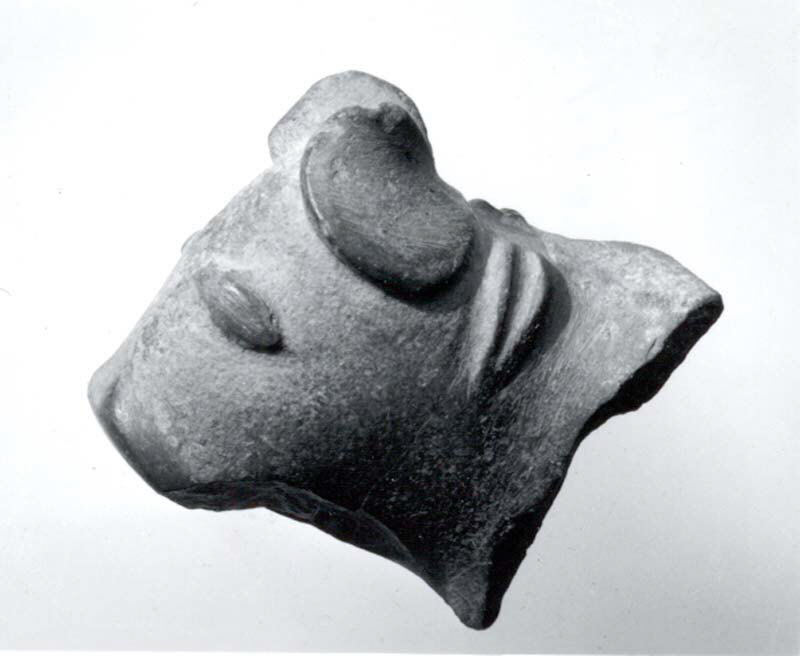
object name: spout of vessel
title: Bull head-shaped spout of vessel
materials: stone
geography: western asia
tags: bulls